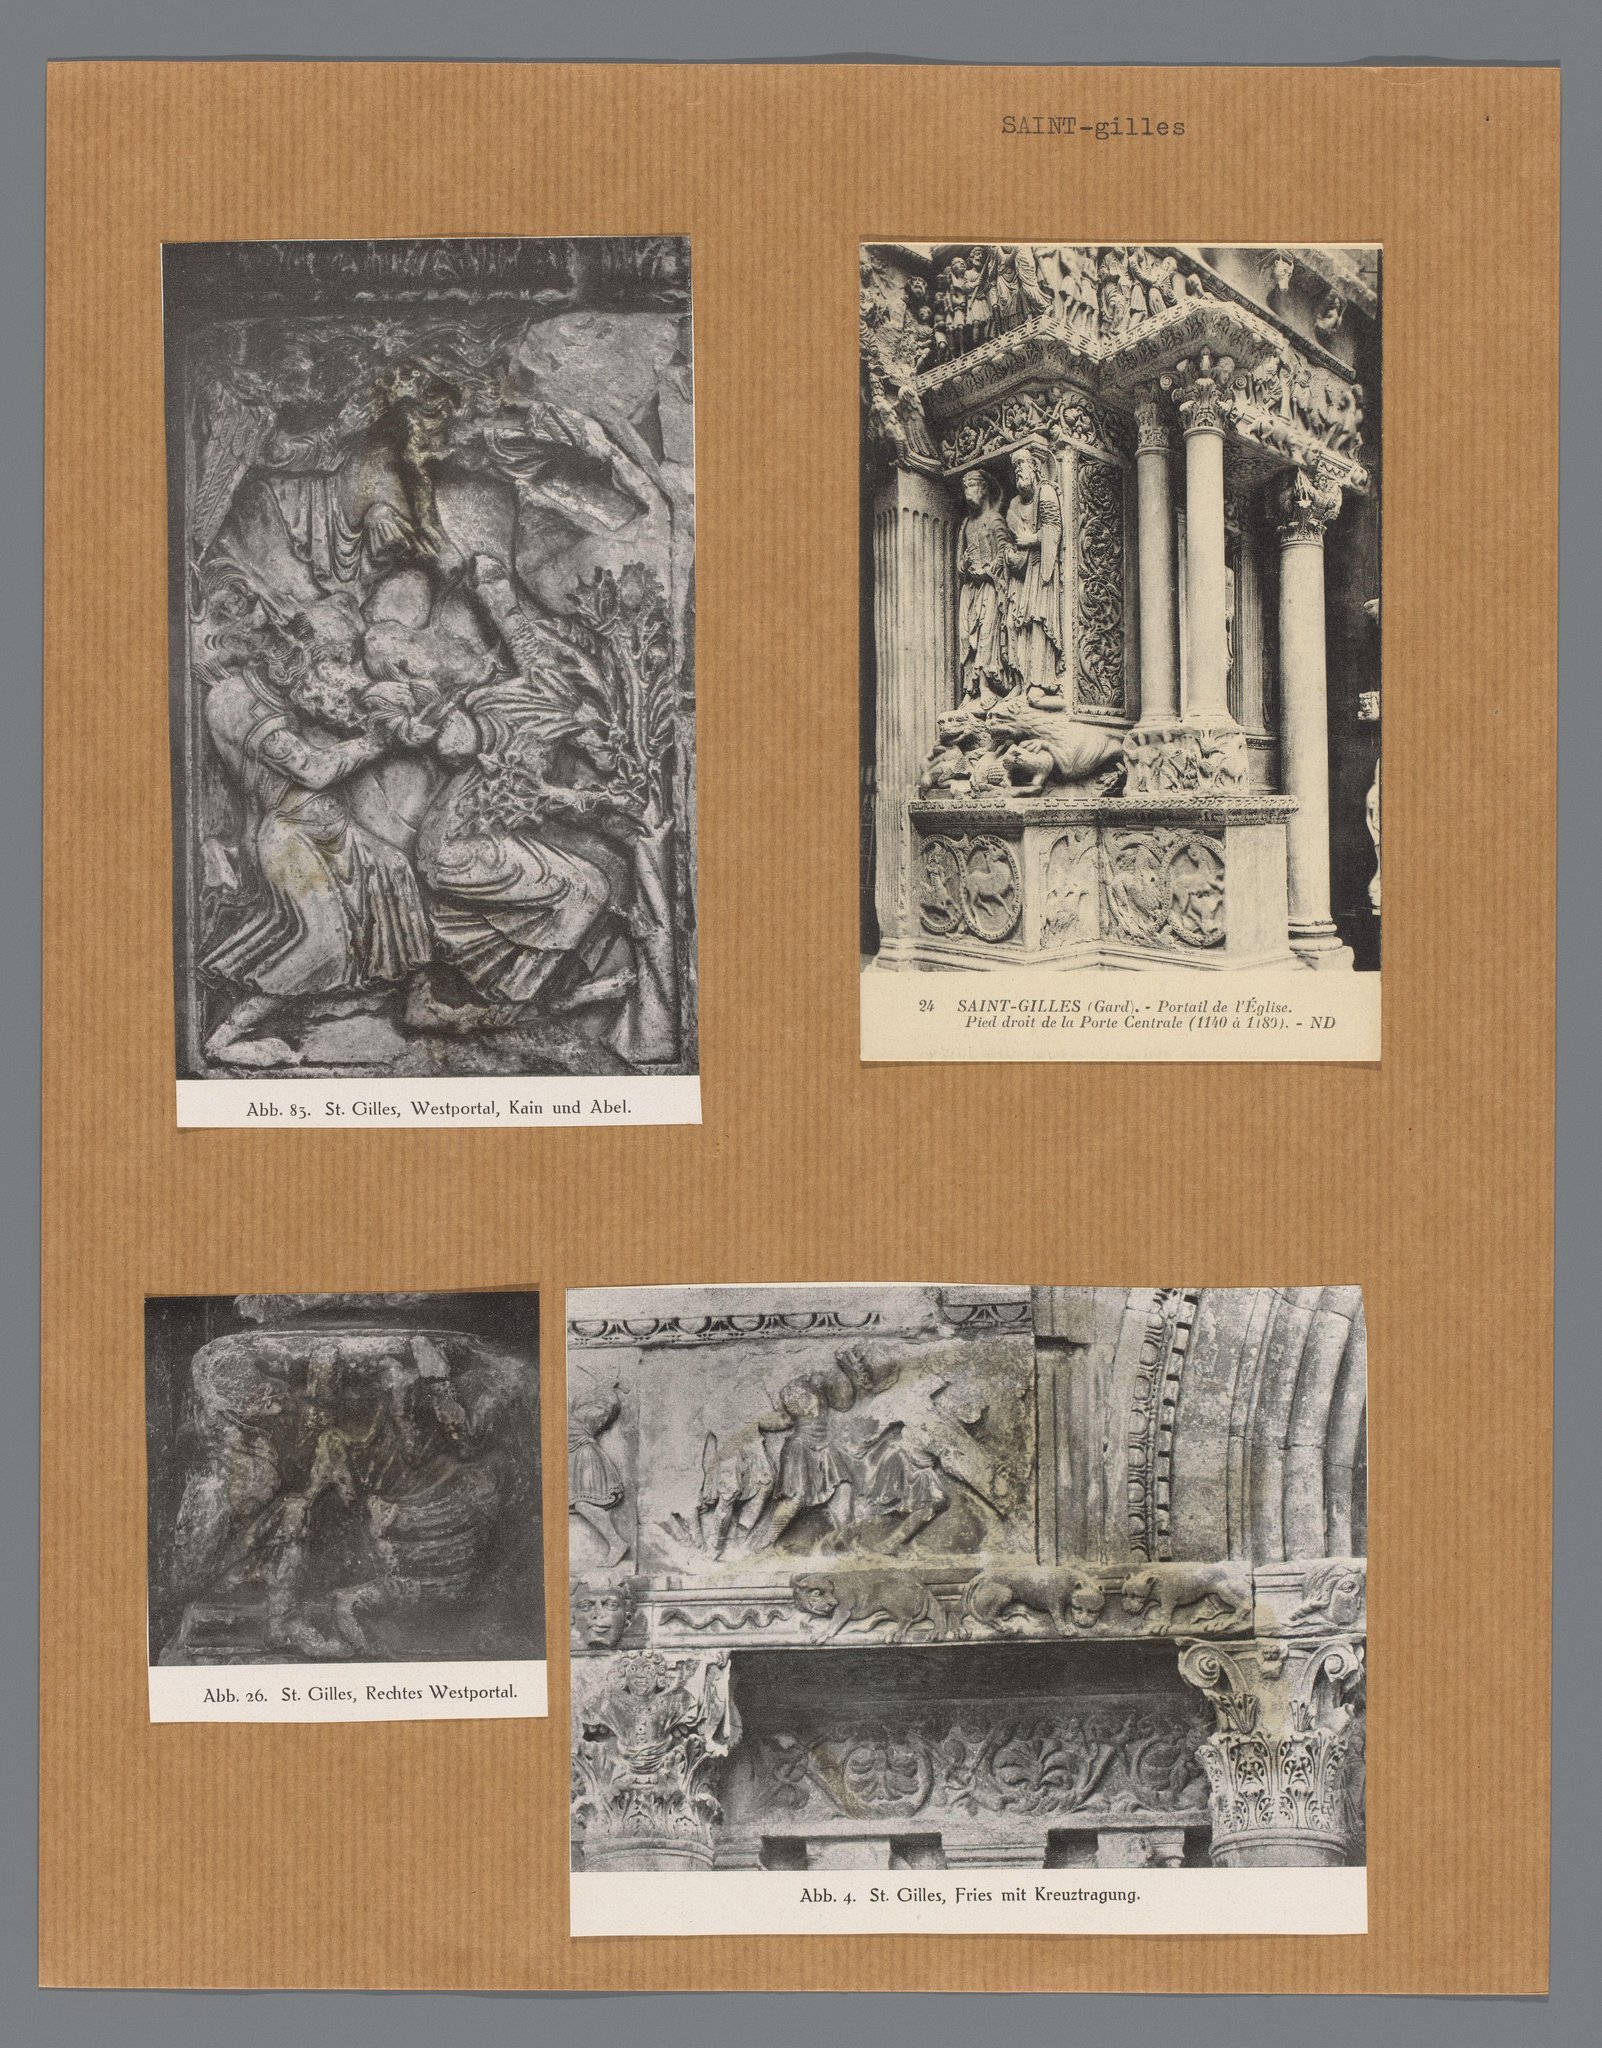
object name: photograph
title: Saint-Gilles, Kirche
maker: Anonymous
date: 1900-1950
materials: paper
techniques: photograph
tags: france